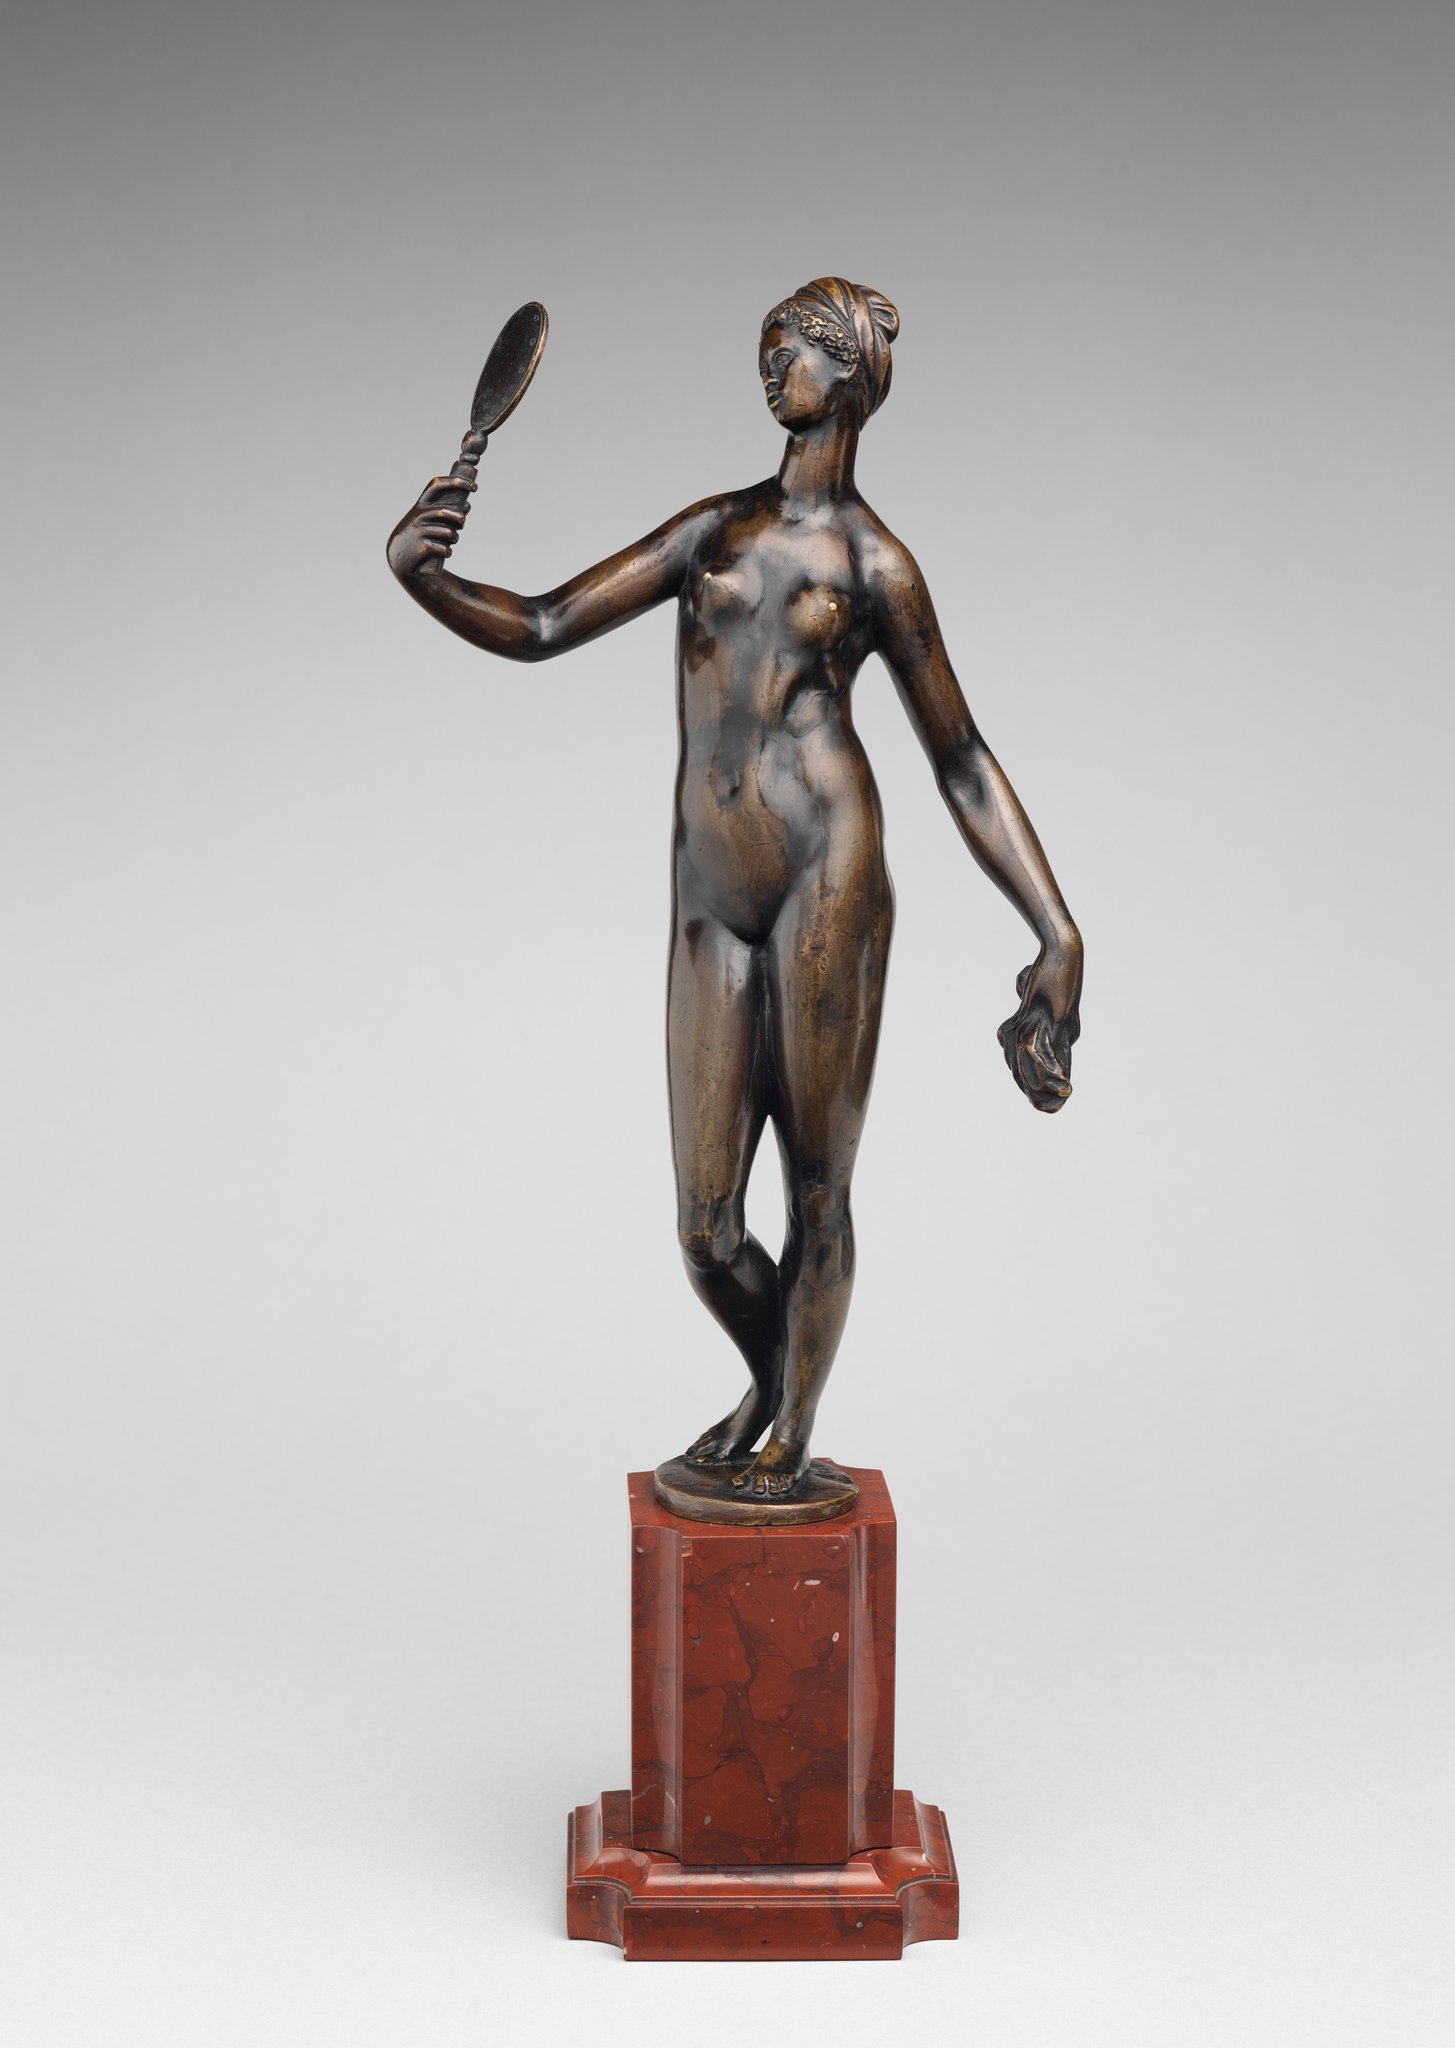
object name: statuette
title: Bather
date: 1567-1633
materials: bronze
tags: venus